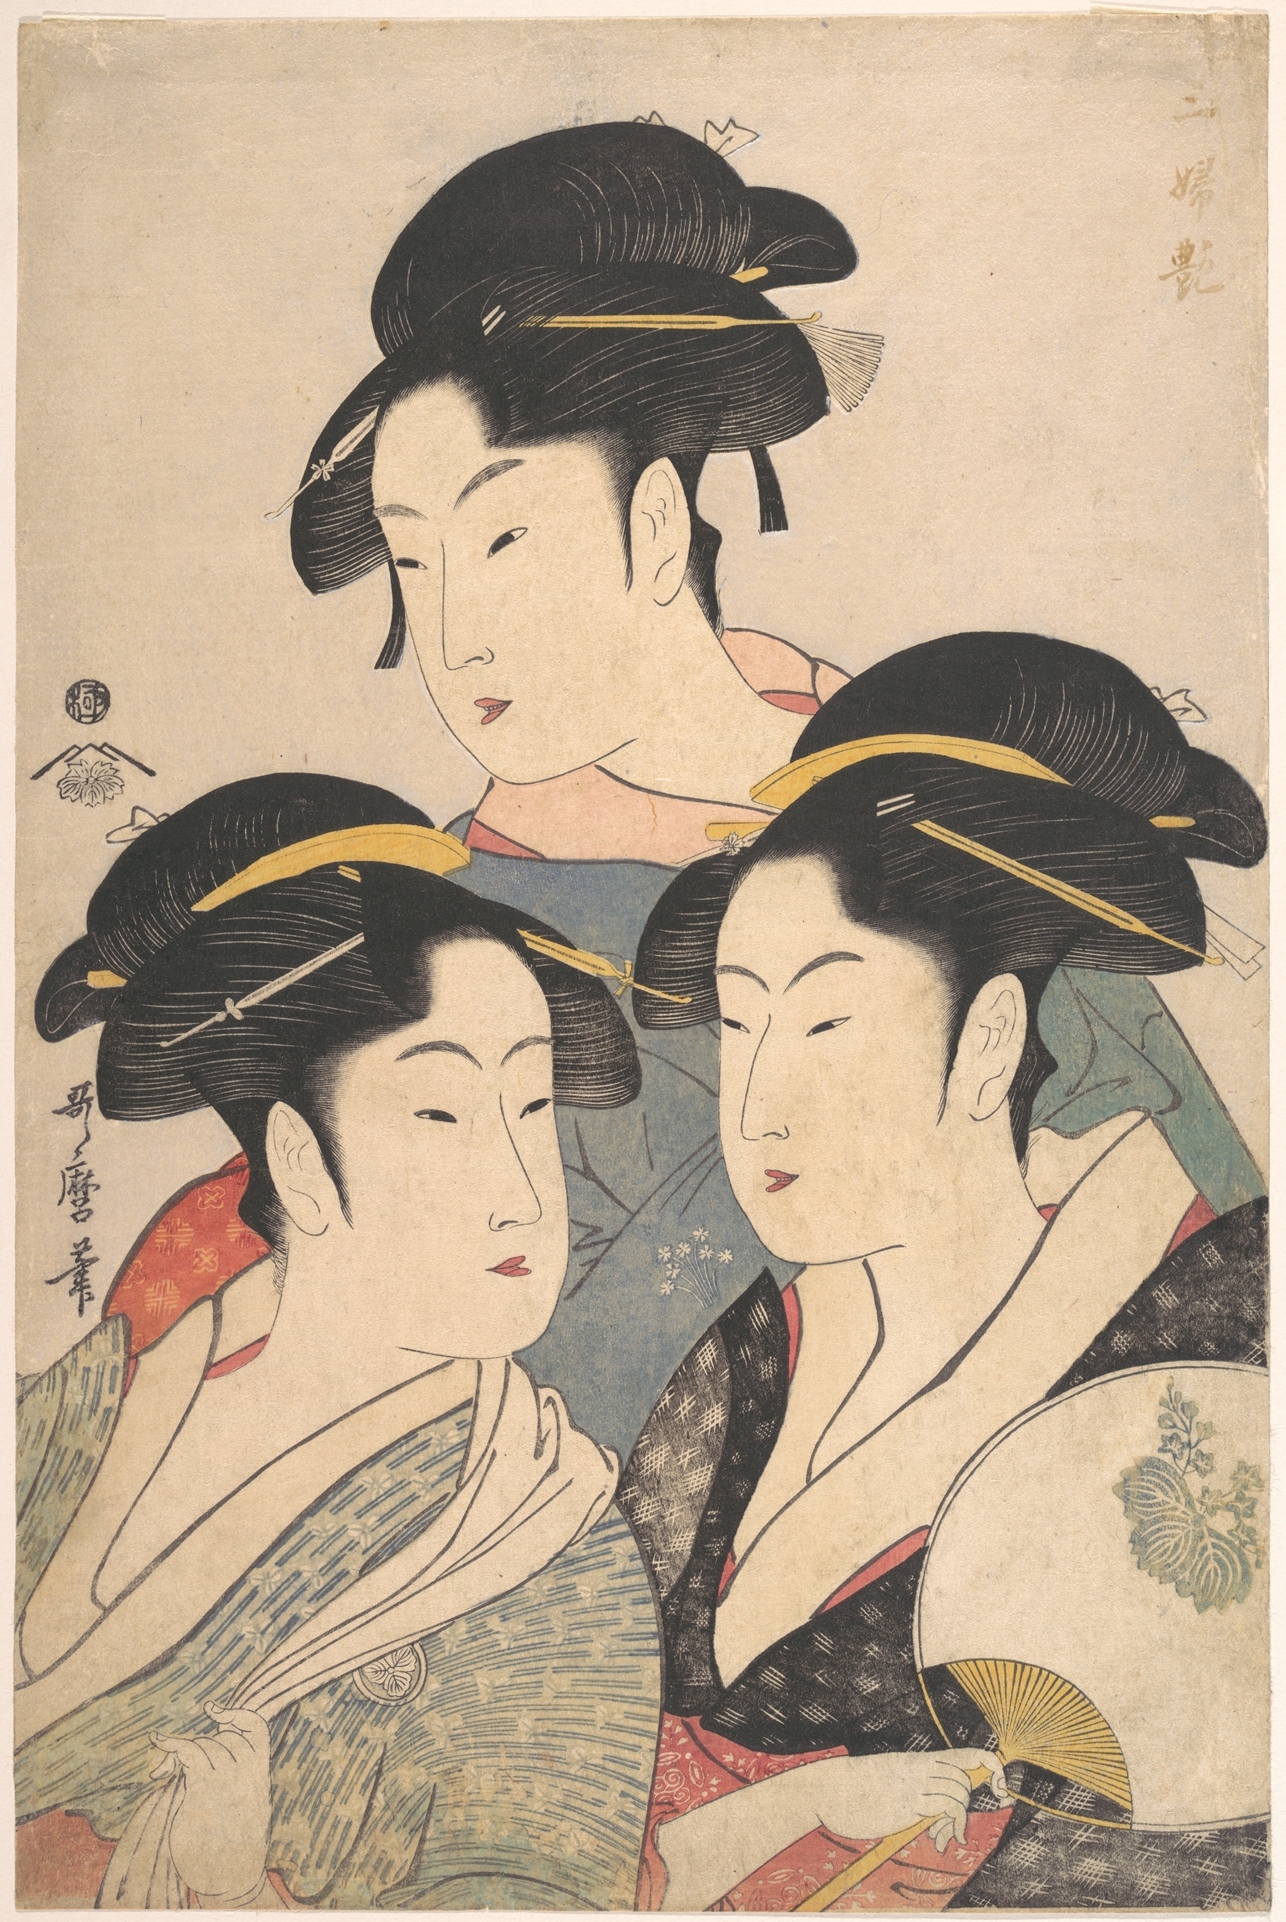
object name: print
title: Three Beauties of the Kwansei Period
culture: japanese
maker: kitagawa utamaro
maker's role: artist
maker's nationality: japanese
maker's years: 1754-1806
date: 1791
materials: ink, paper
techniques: woodblock print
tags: fans,women